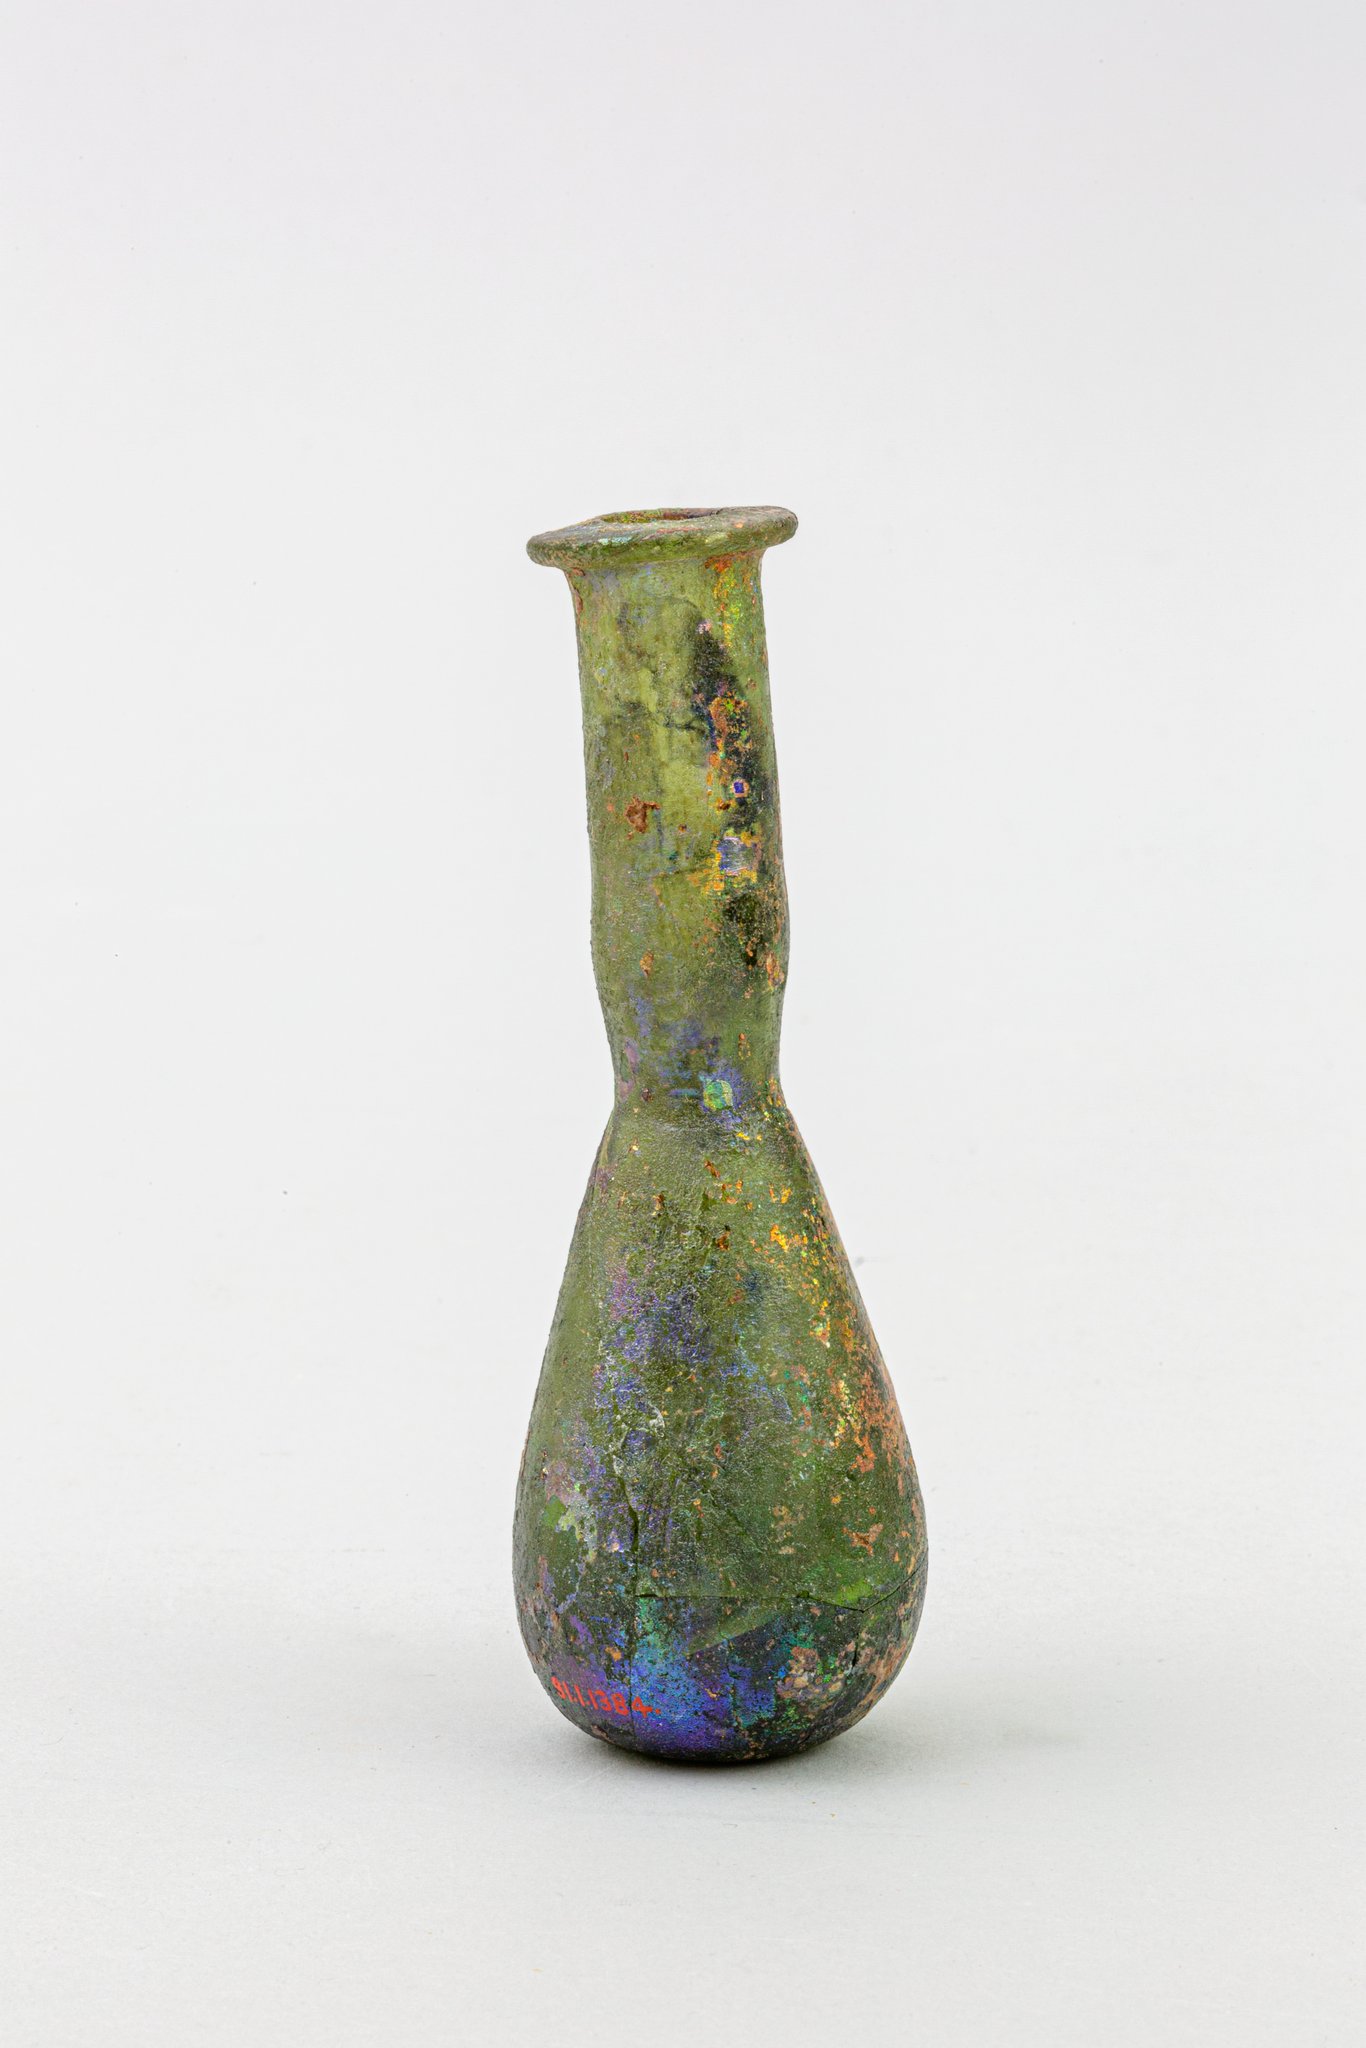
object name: perfume bottle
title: Glass perfume bottle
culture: roman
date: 67-300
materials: glass